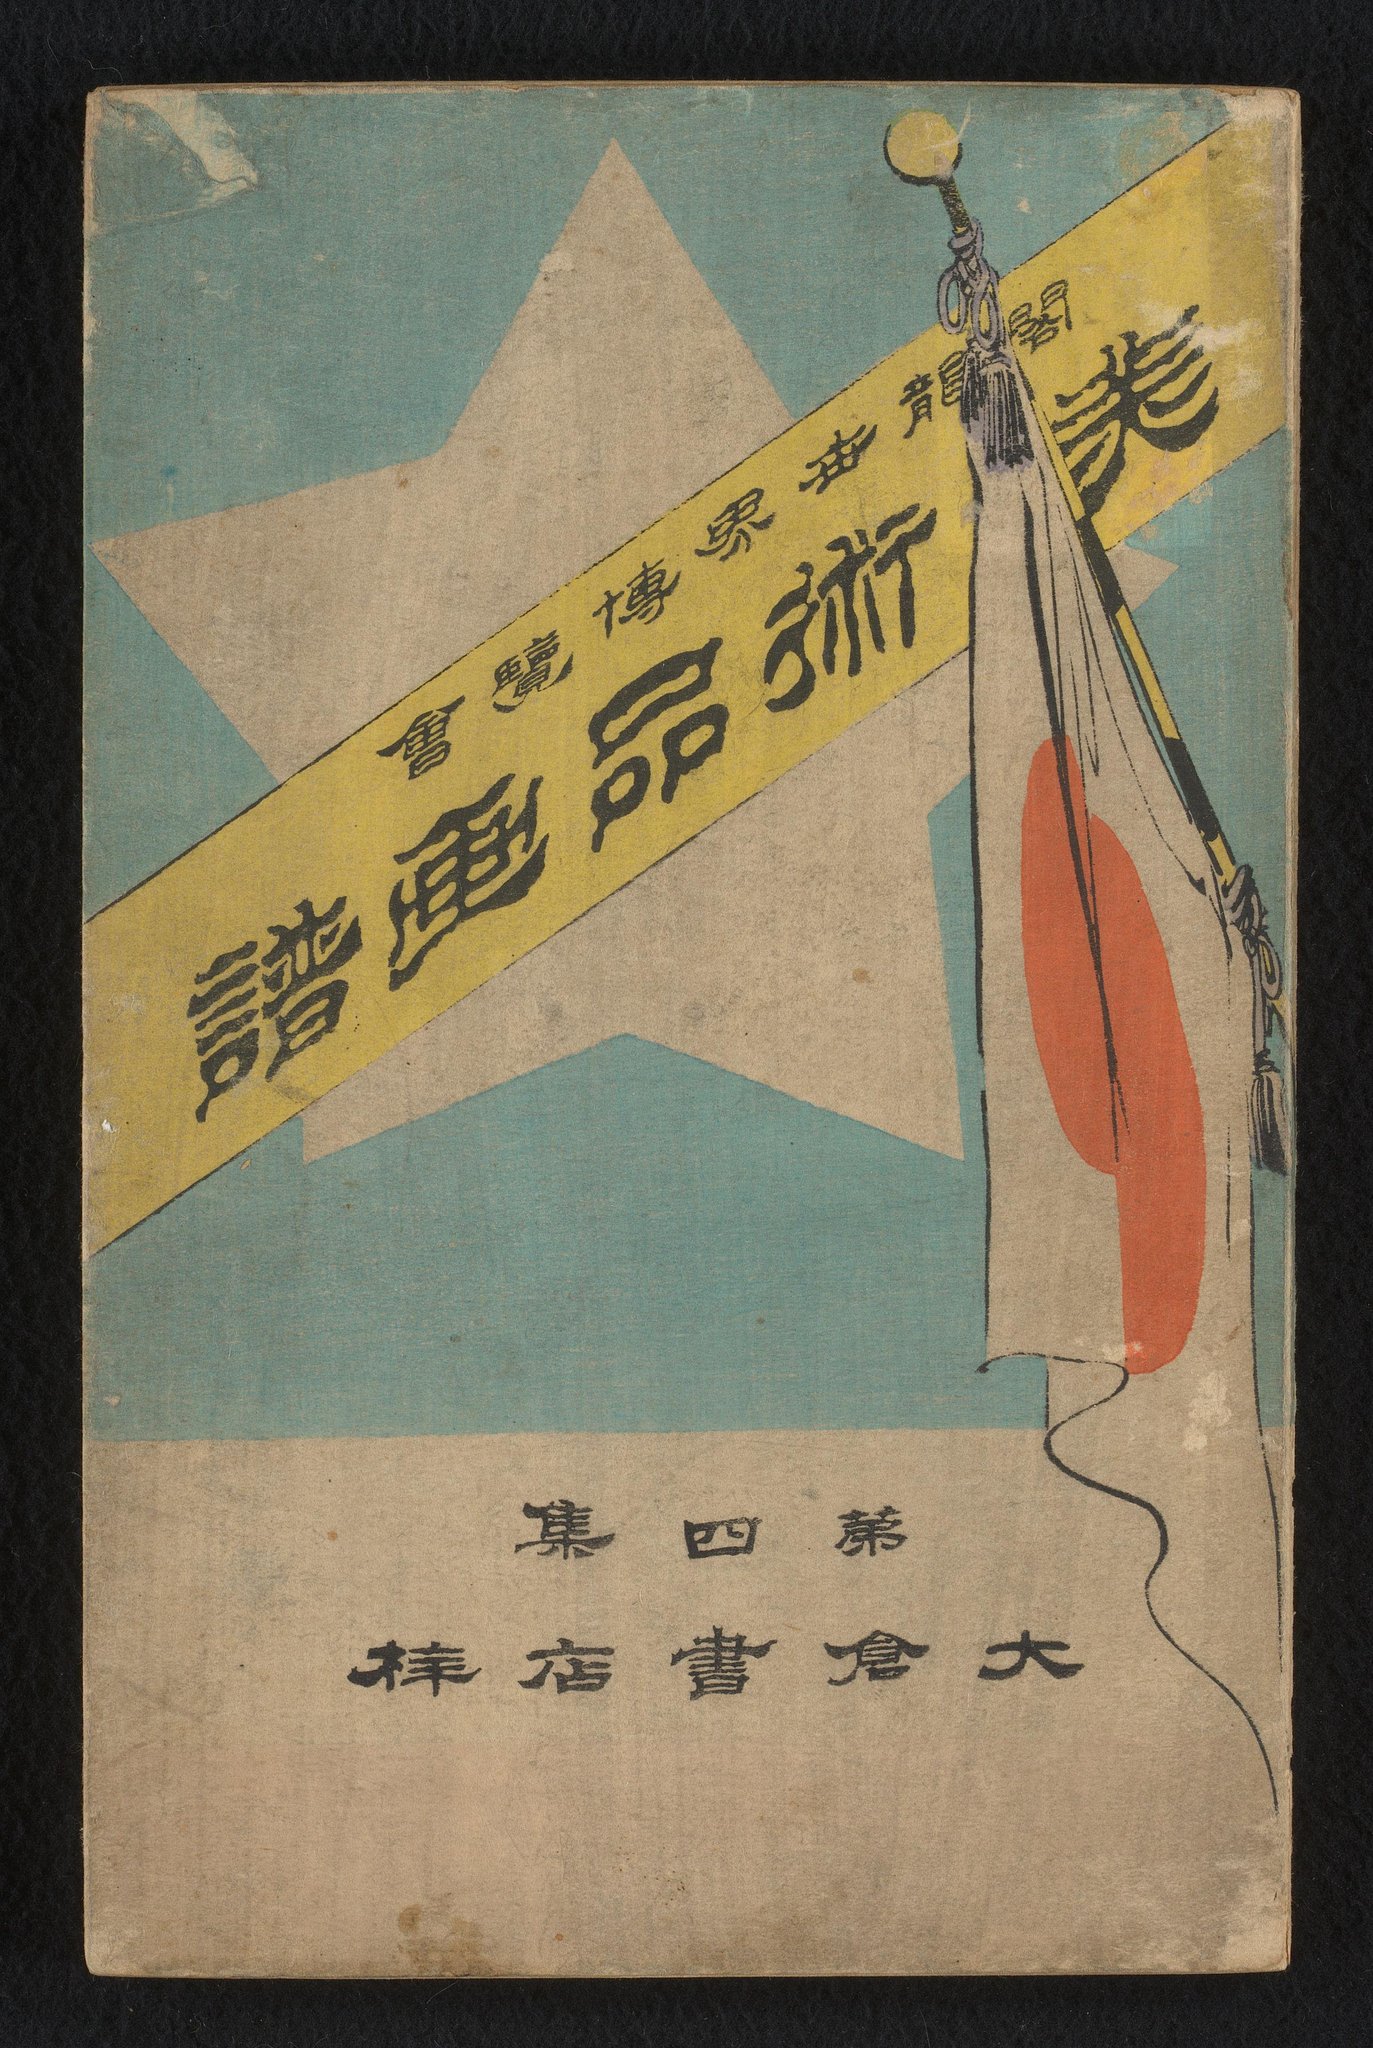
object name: book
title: World`s Columbian exposition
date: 1807-1894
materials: paper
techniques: woodcut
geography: tokyo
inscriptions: date